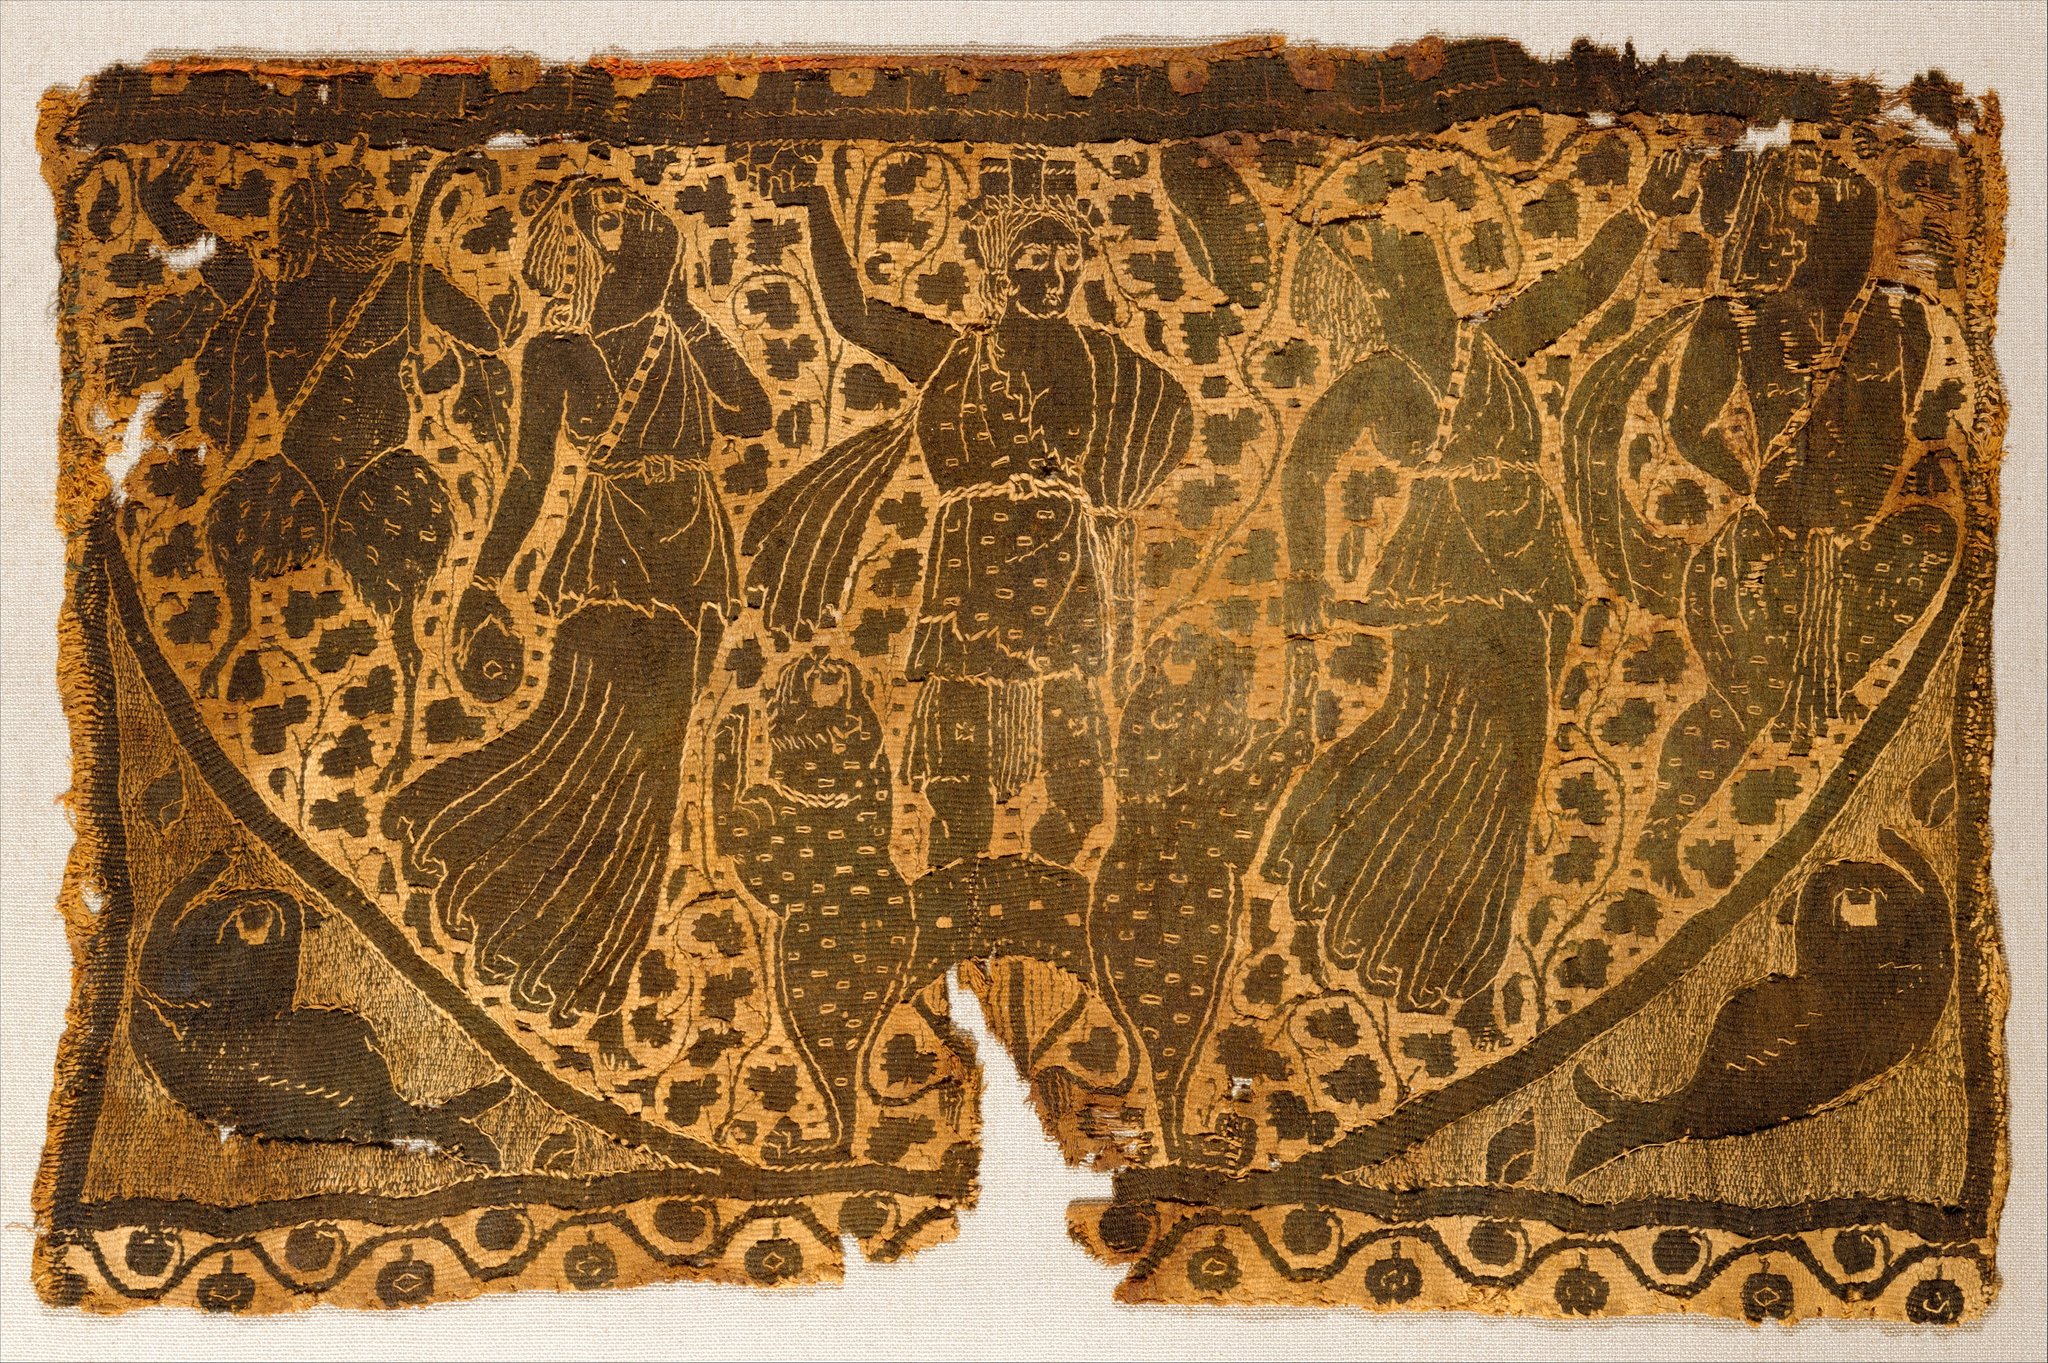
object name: panel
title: Panel with the Triumph of Dionysos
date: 301-600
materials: linen, wool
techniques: weave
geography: egypt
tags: women,dionysus,satyrs,dolphins,panthers